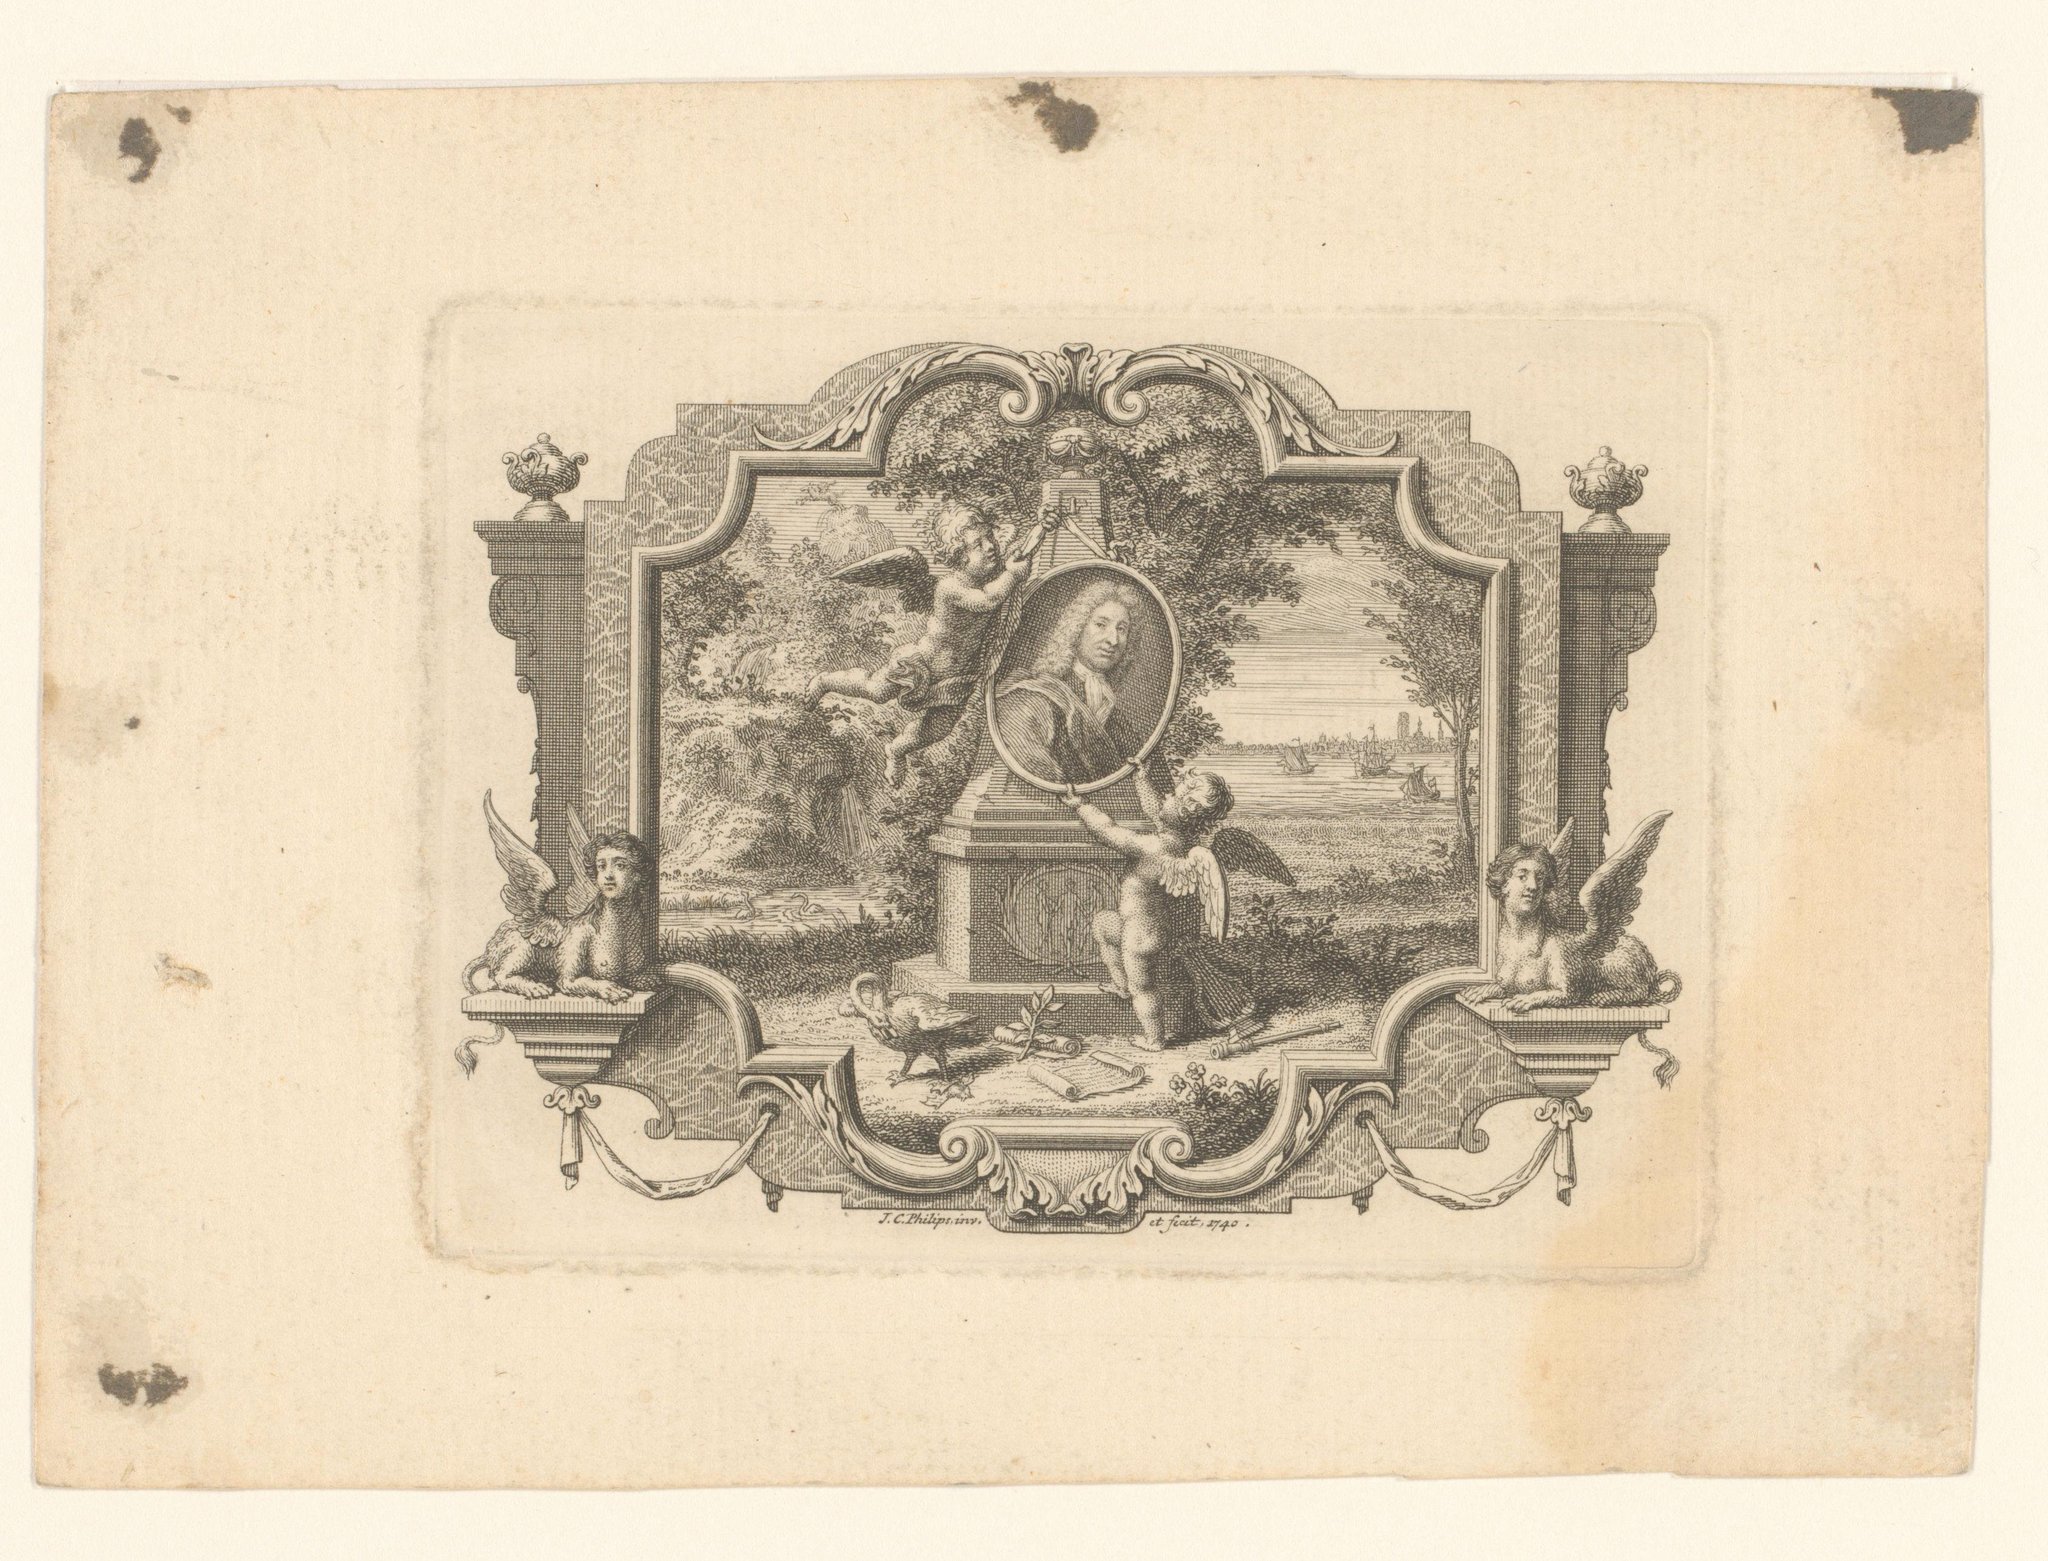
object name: print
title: Twee putti bevestigen portret van Pieter Rabus aan gedenkmonument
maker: jan caspar philips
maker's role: draughtsman, print maker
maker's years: 1700-1775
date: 1740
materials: paper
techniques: etching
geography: amsterdam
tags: pieter rabus, sphinx (lion/woman); 'sfinge' (ripa) - aa - female human figure, ornament ~ medallion, historical persons, portrait of a writer, ornament ~ cartouche, grave, tomb and other grave-forms and grave-markers, cupids: 'amores', 'amoretti', 'putti', rotterdam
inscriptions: collector's mark: Lugt 2228, collector's mark: Lugt 2760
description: Cartouche met aan weerszijden een sfinx. Op de achtergrond een gezicht op Rotterdam.